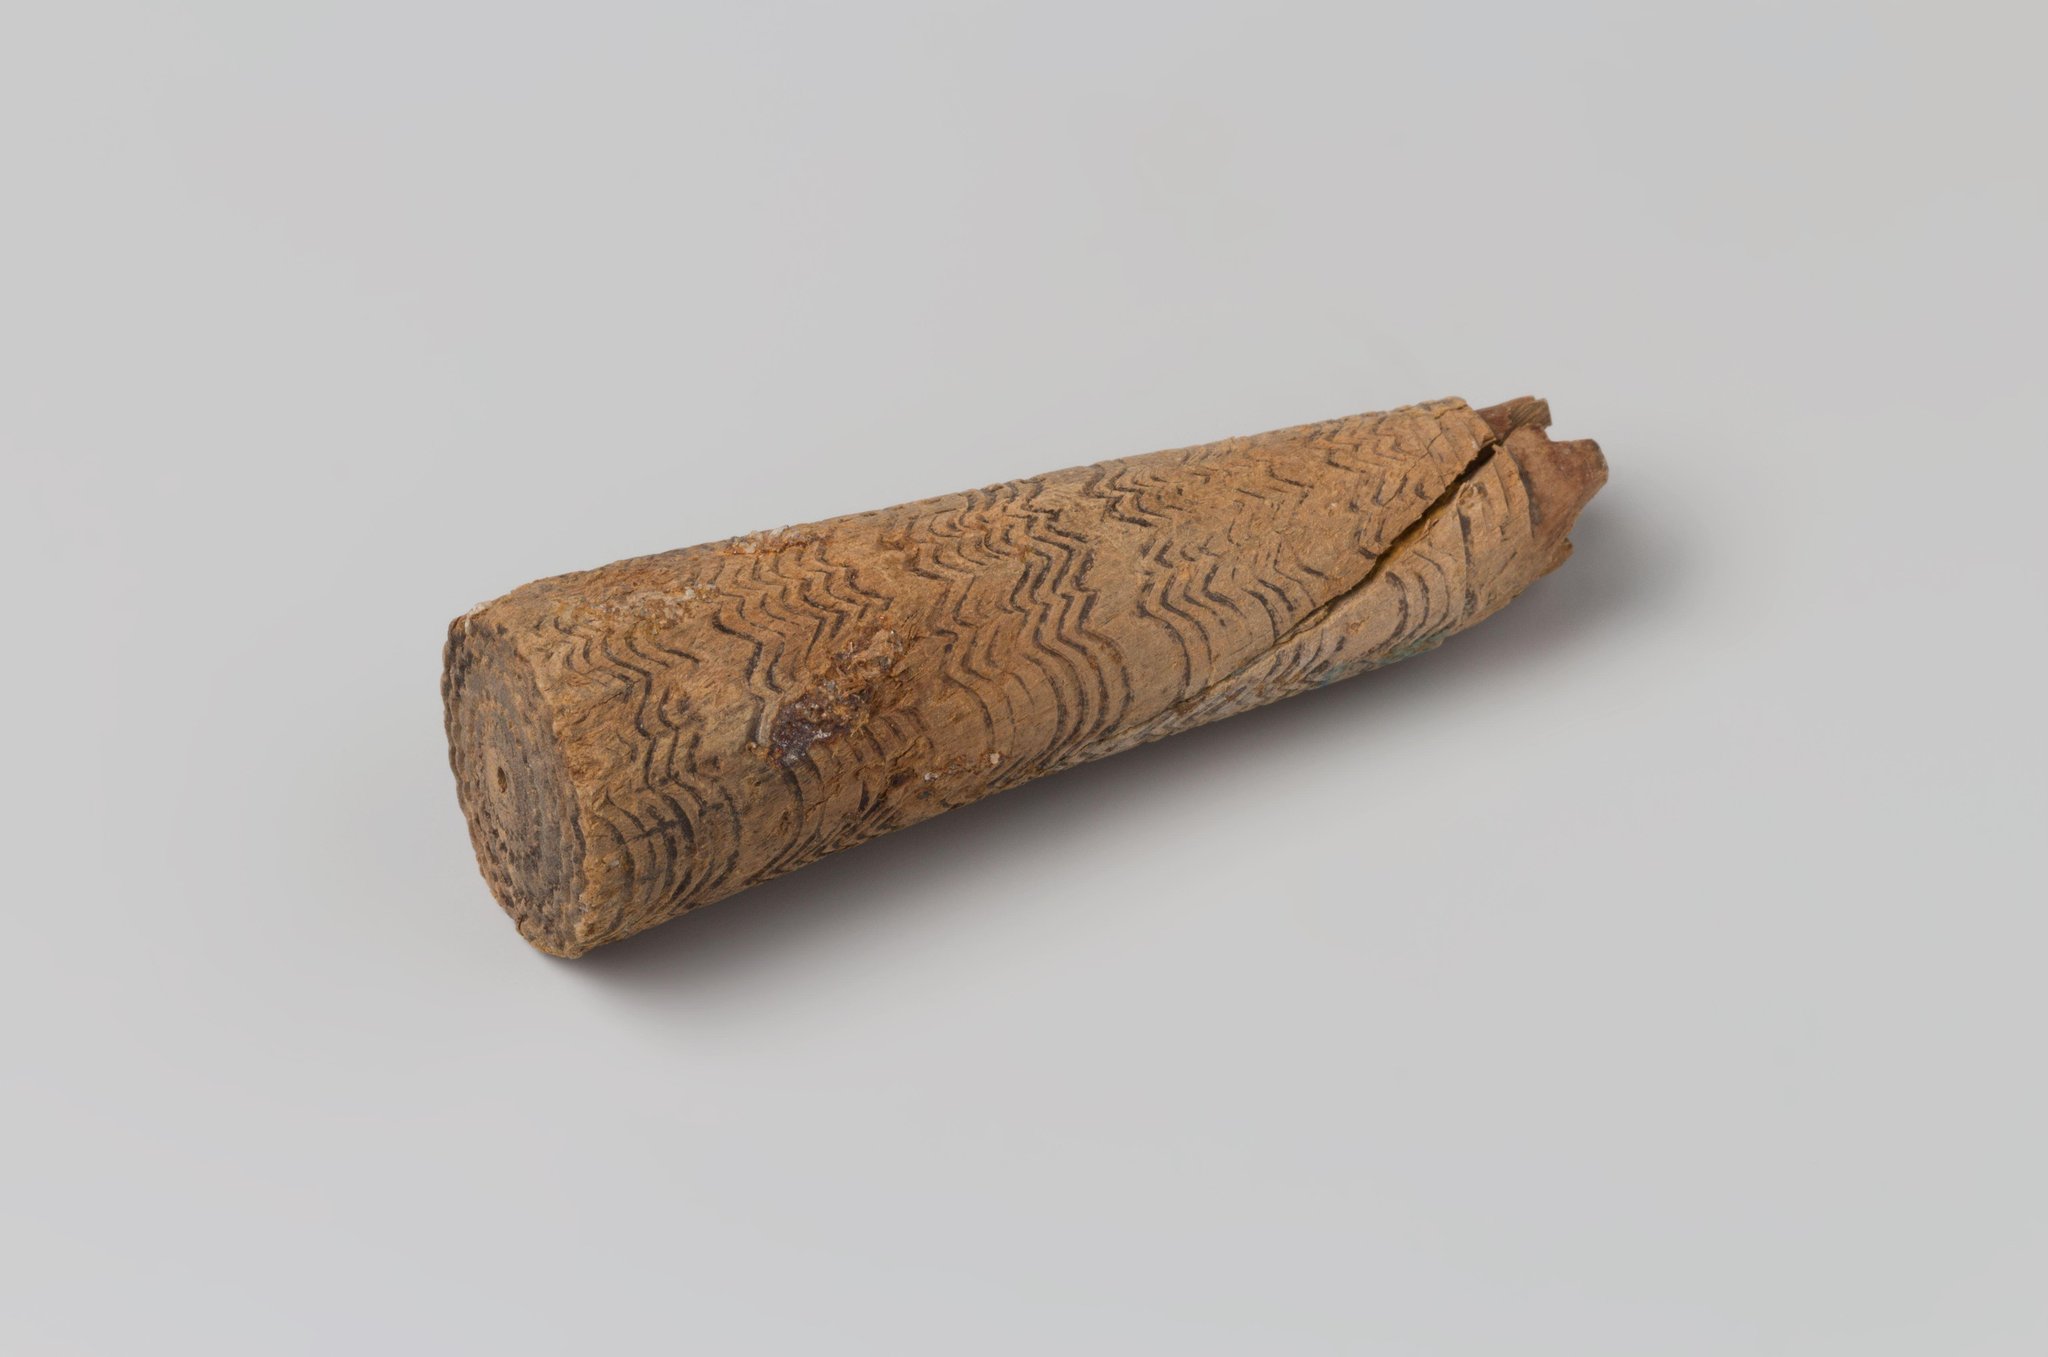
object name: knife handle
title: Messenheft uit het wrak van de Oost-Indiëvaarder Hollandia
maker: Anonymous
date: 1700-1743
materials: wood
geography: netherlands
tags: verenigde oostindische compagnie, hollandia (schip), annet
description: Knife, handle, cylindrical: tapering; id. NG 1979-403H, ferrules, id. NG 1980-27H426.